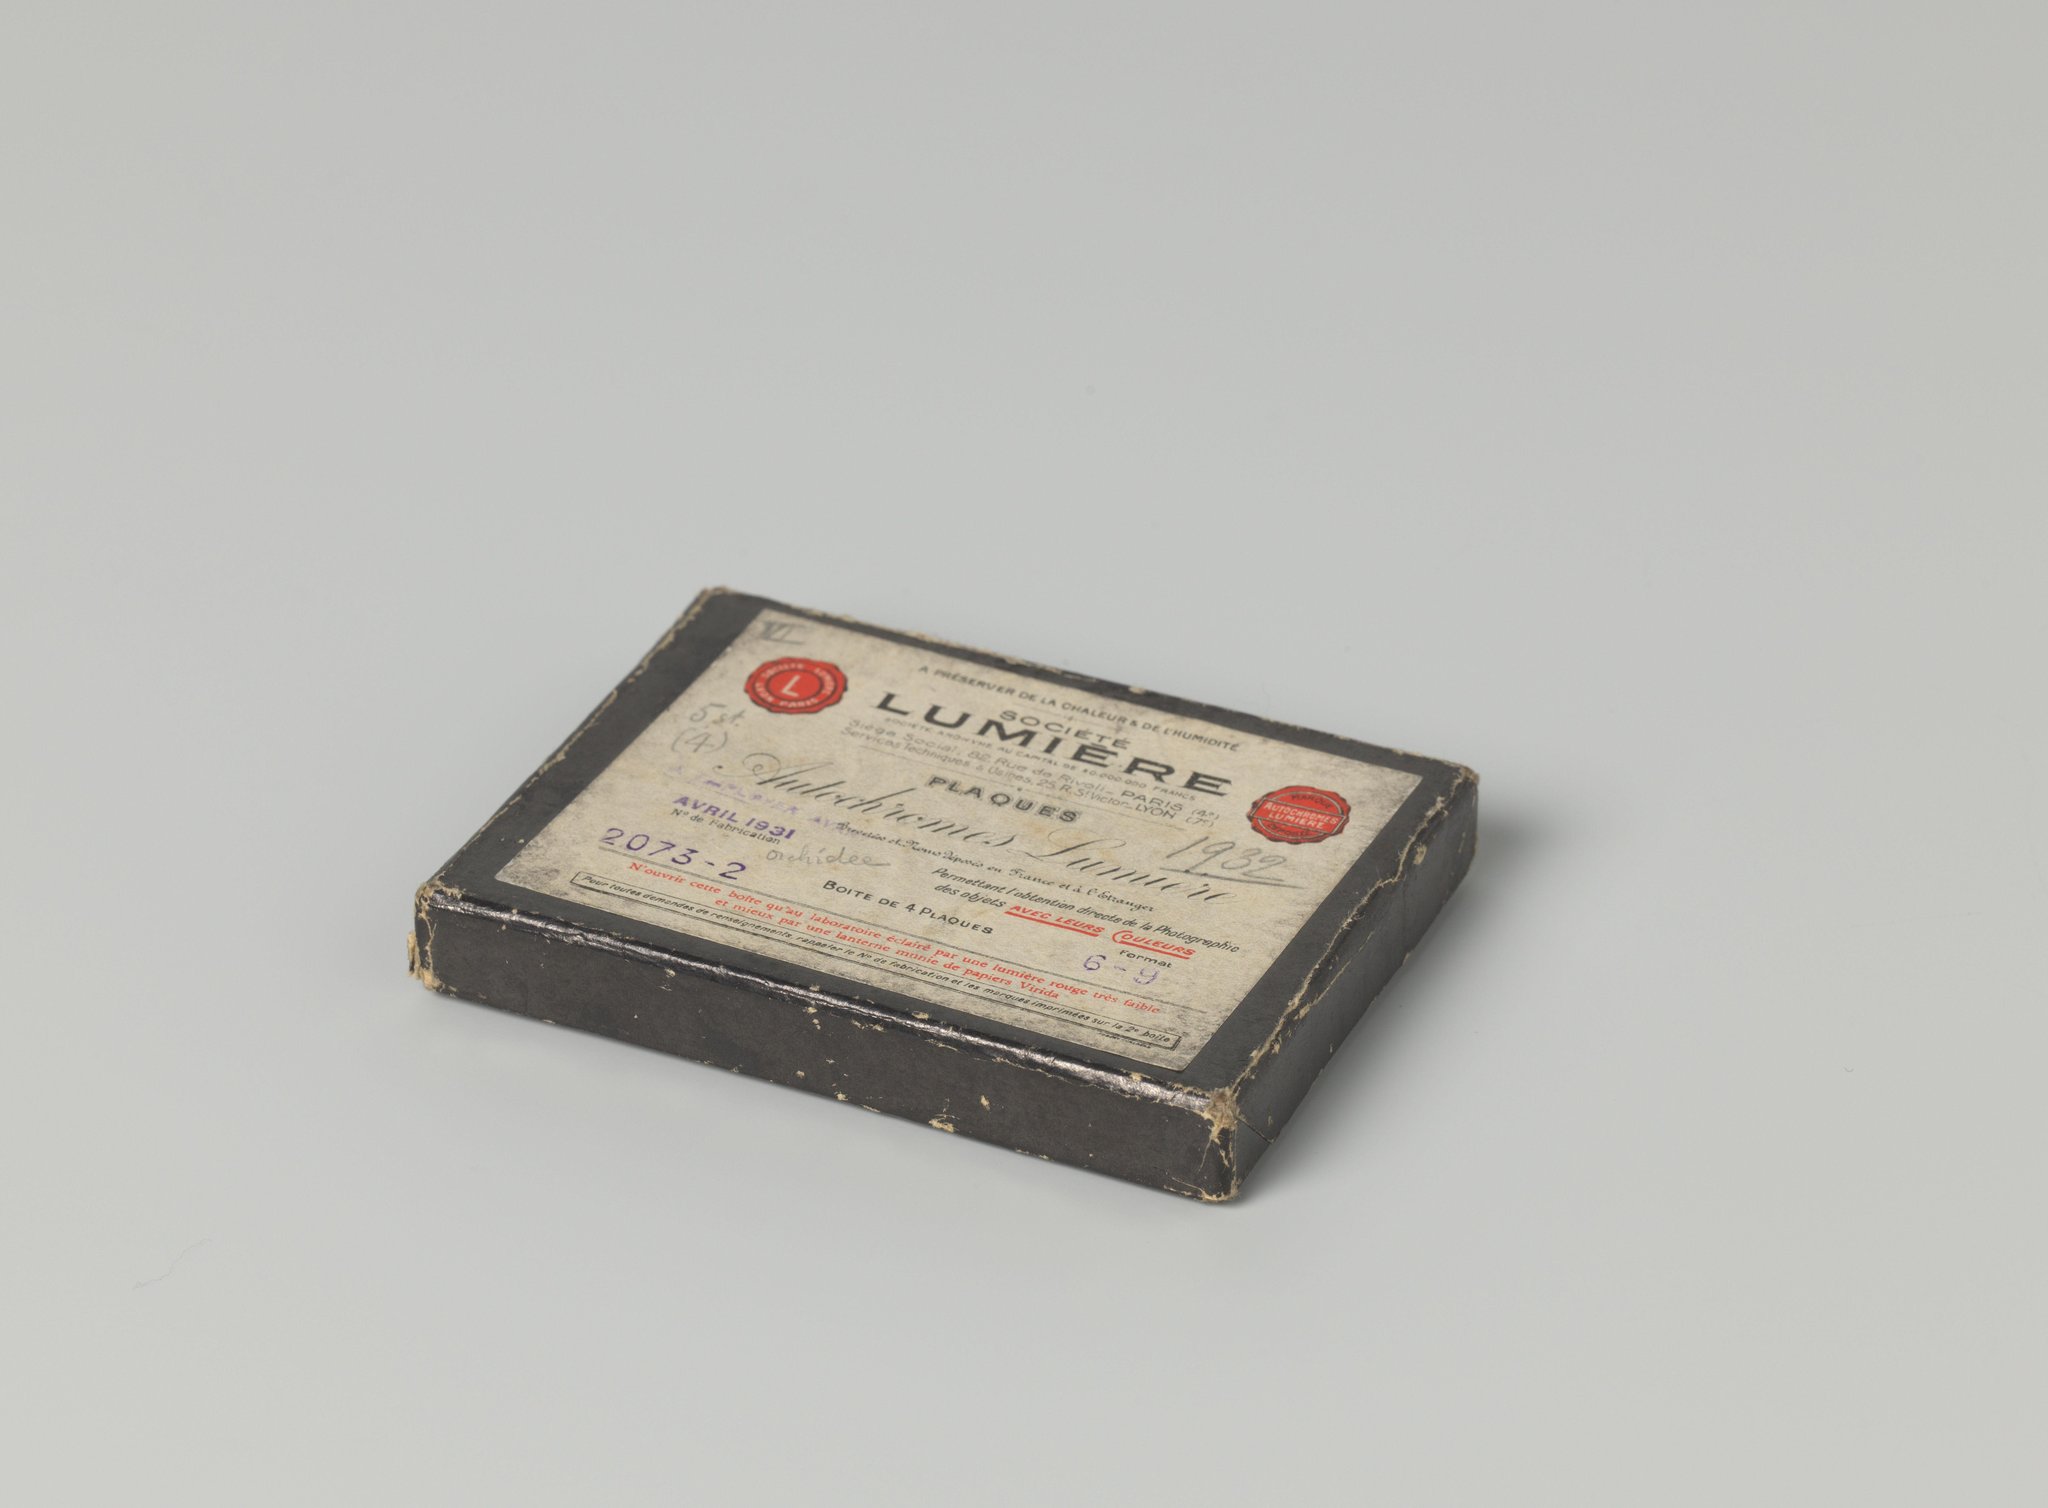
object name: box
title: Doos voor autochromes van Lumière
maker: lumière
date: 1931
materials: cardboard, paper, tape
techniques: printing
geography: france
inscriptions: date: ‘1932’, inscription: ‘VI/ 5 st./ (4)’, stamp: ‘AVRIL 1931’